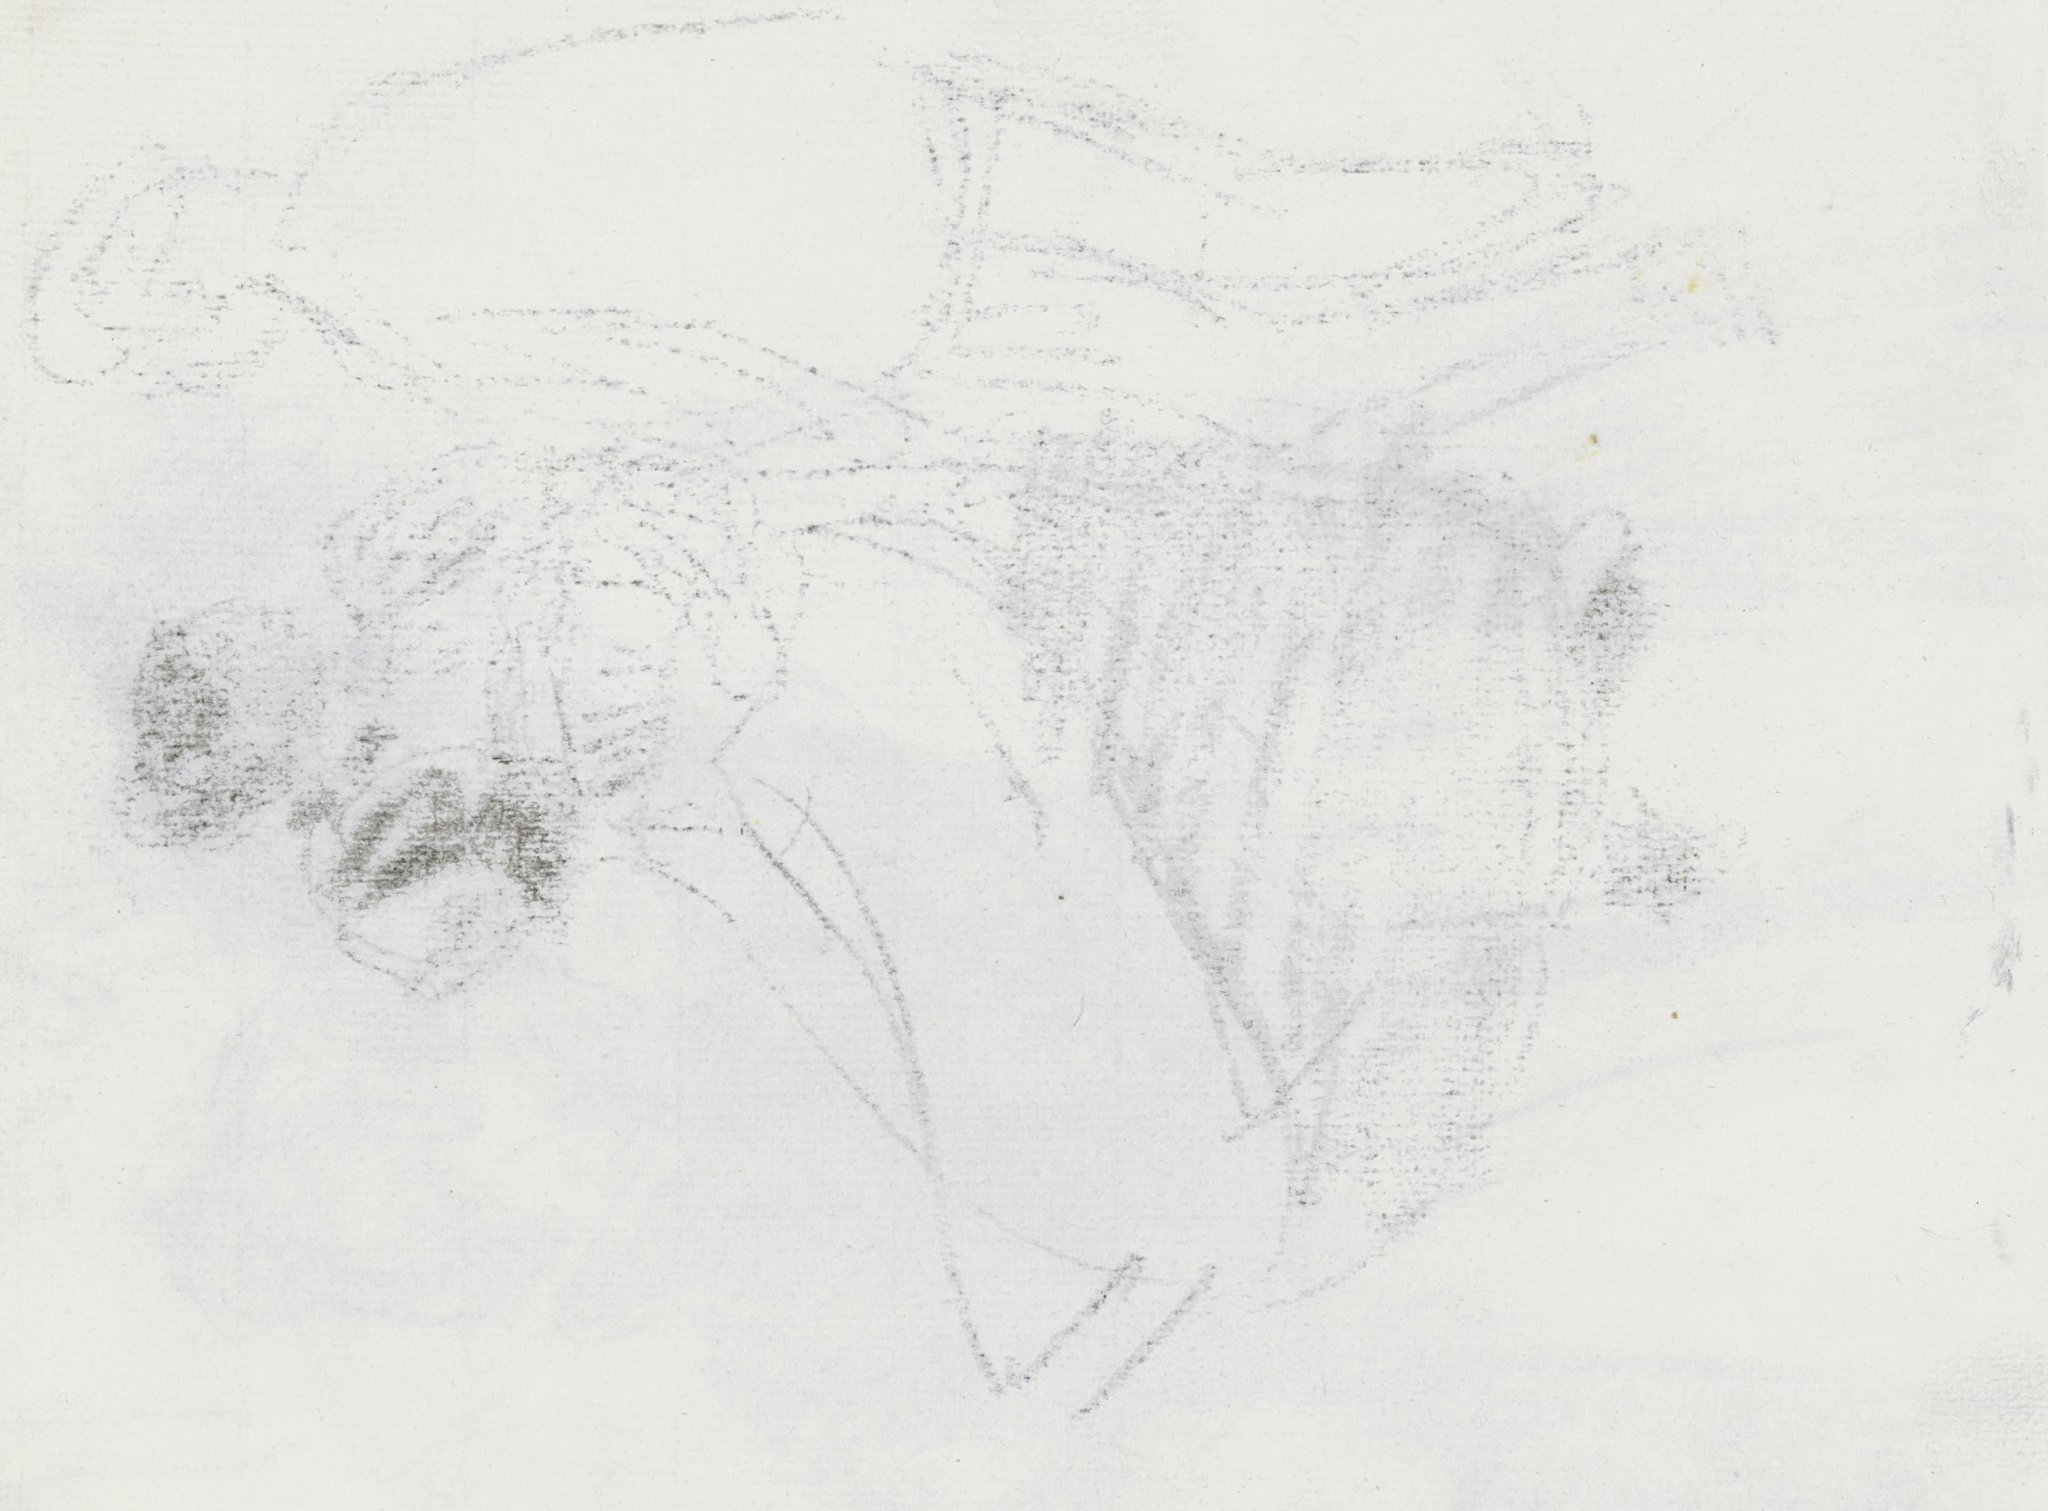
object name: sketchbook leaf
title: Abklatsch van de krijttekening op blad 15 recto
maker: isaac israels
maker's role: draughtsman, painter, print maker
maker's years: 1865-1934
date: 1875-1934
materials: paper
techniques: printmaking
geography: amsterdam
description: Blad 14 verso uit schetsboek XX met 26 bladen.